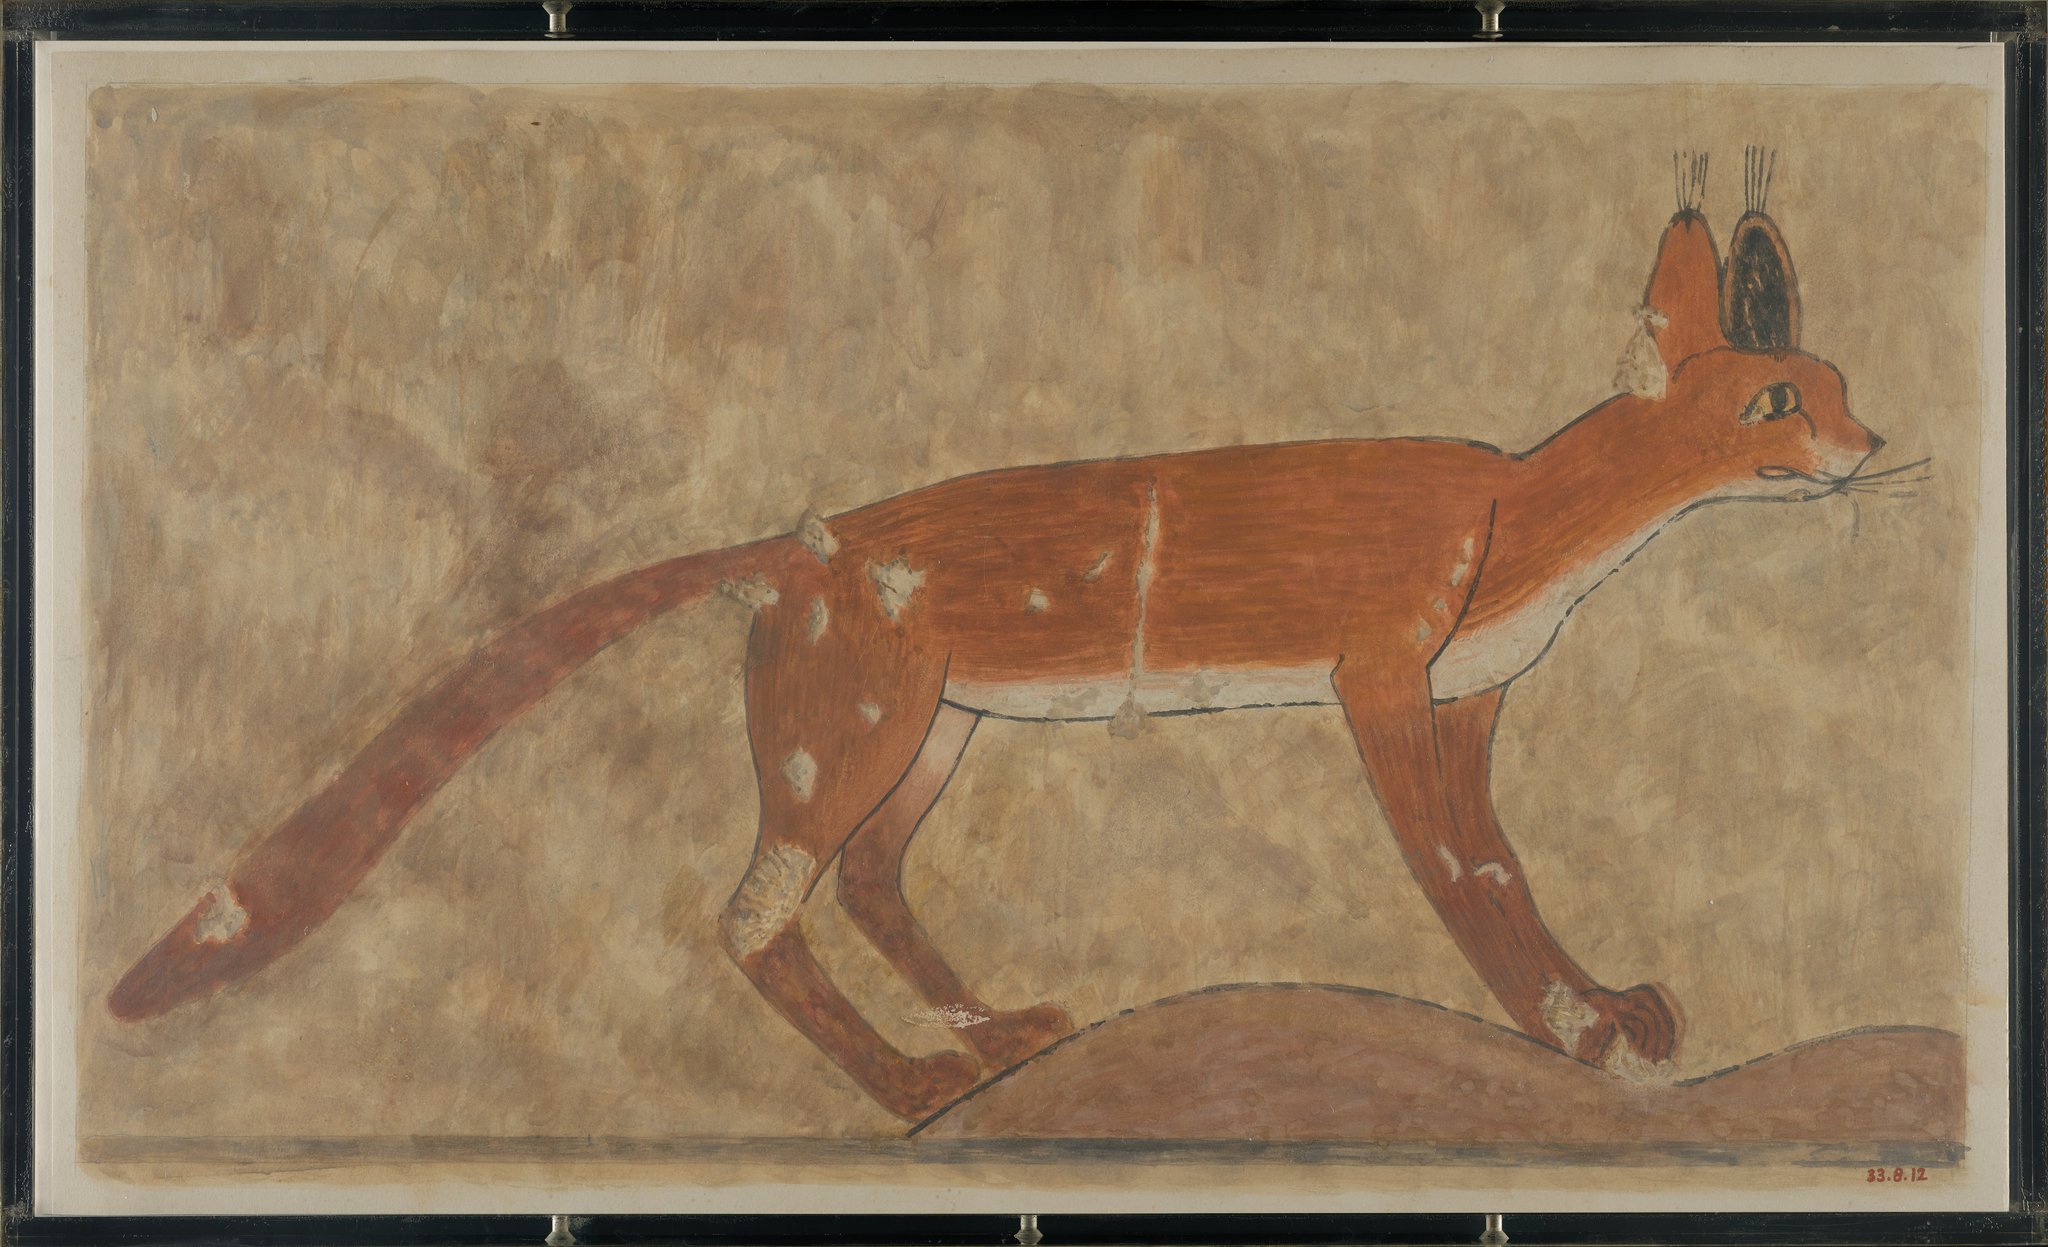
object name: facsimile, khnumhotep beni hasan 3, desert animal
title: Detail of a Wild Feline, Tomb of Khnumhotep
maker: nina de garis davies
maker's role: artist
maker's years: 1881-1965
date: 1897-1878 BCE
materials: paper, paint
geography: egypt